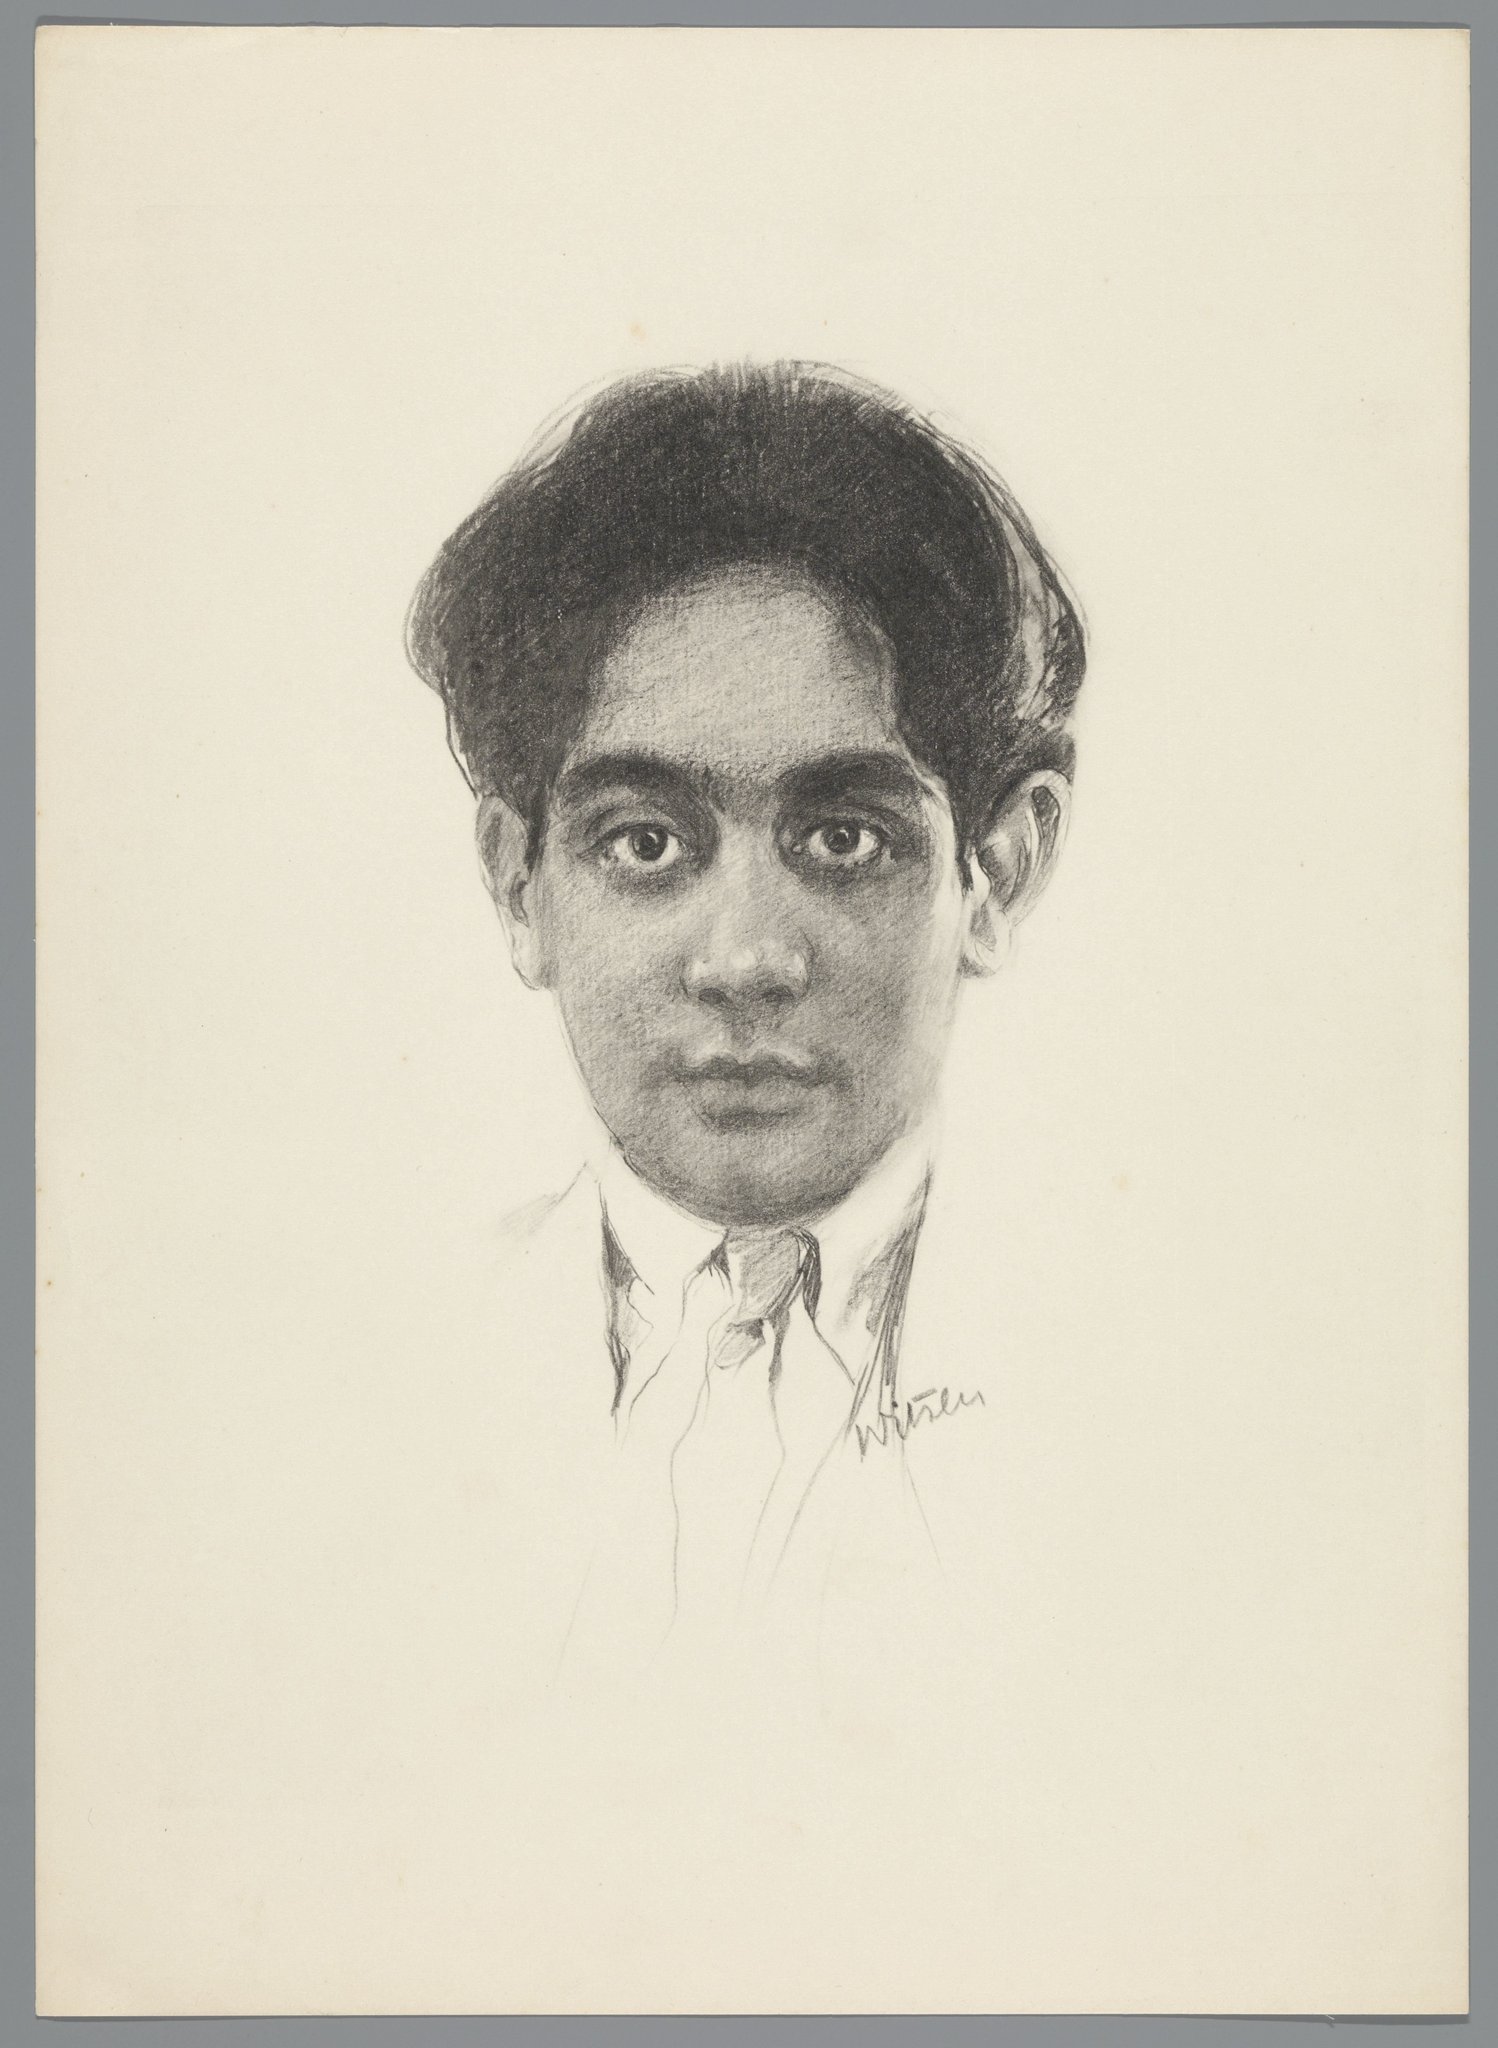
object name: photomechanical print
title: Reproductie van tekening met portret van Karamjit Singh Sahib Bahadur, prins van Kapurthala, door Willem Witsen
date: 1915-1916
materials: paper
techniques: photograph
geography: netherlands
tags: politician, historical persons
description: Voor schilderij van de geportretteerde door Witsen, zie collectie Dordrechts Museum (bruikleen RCE).